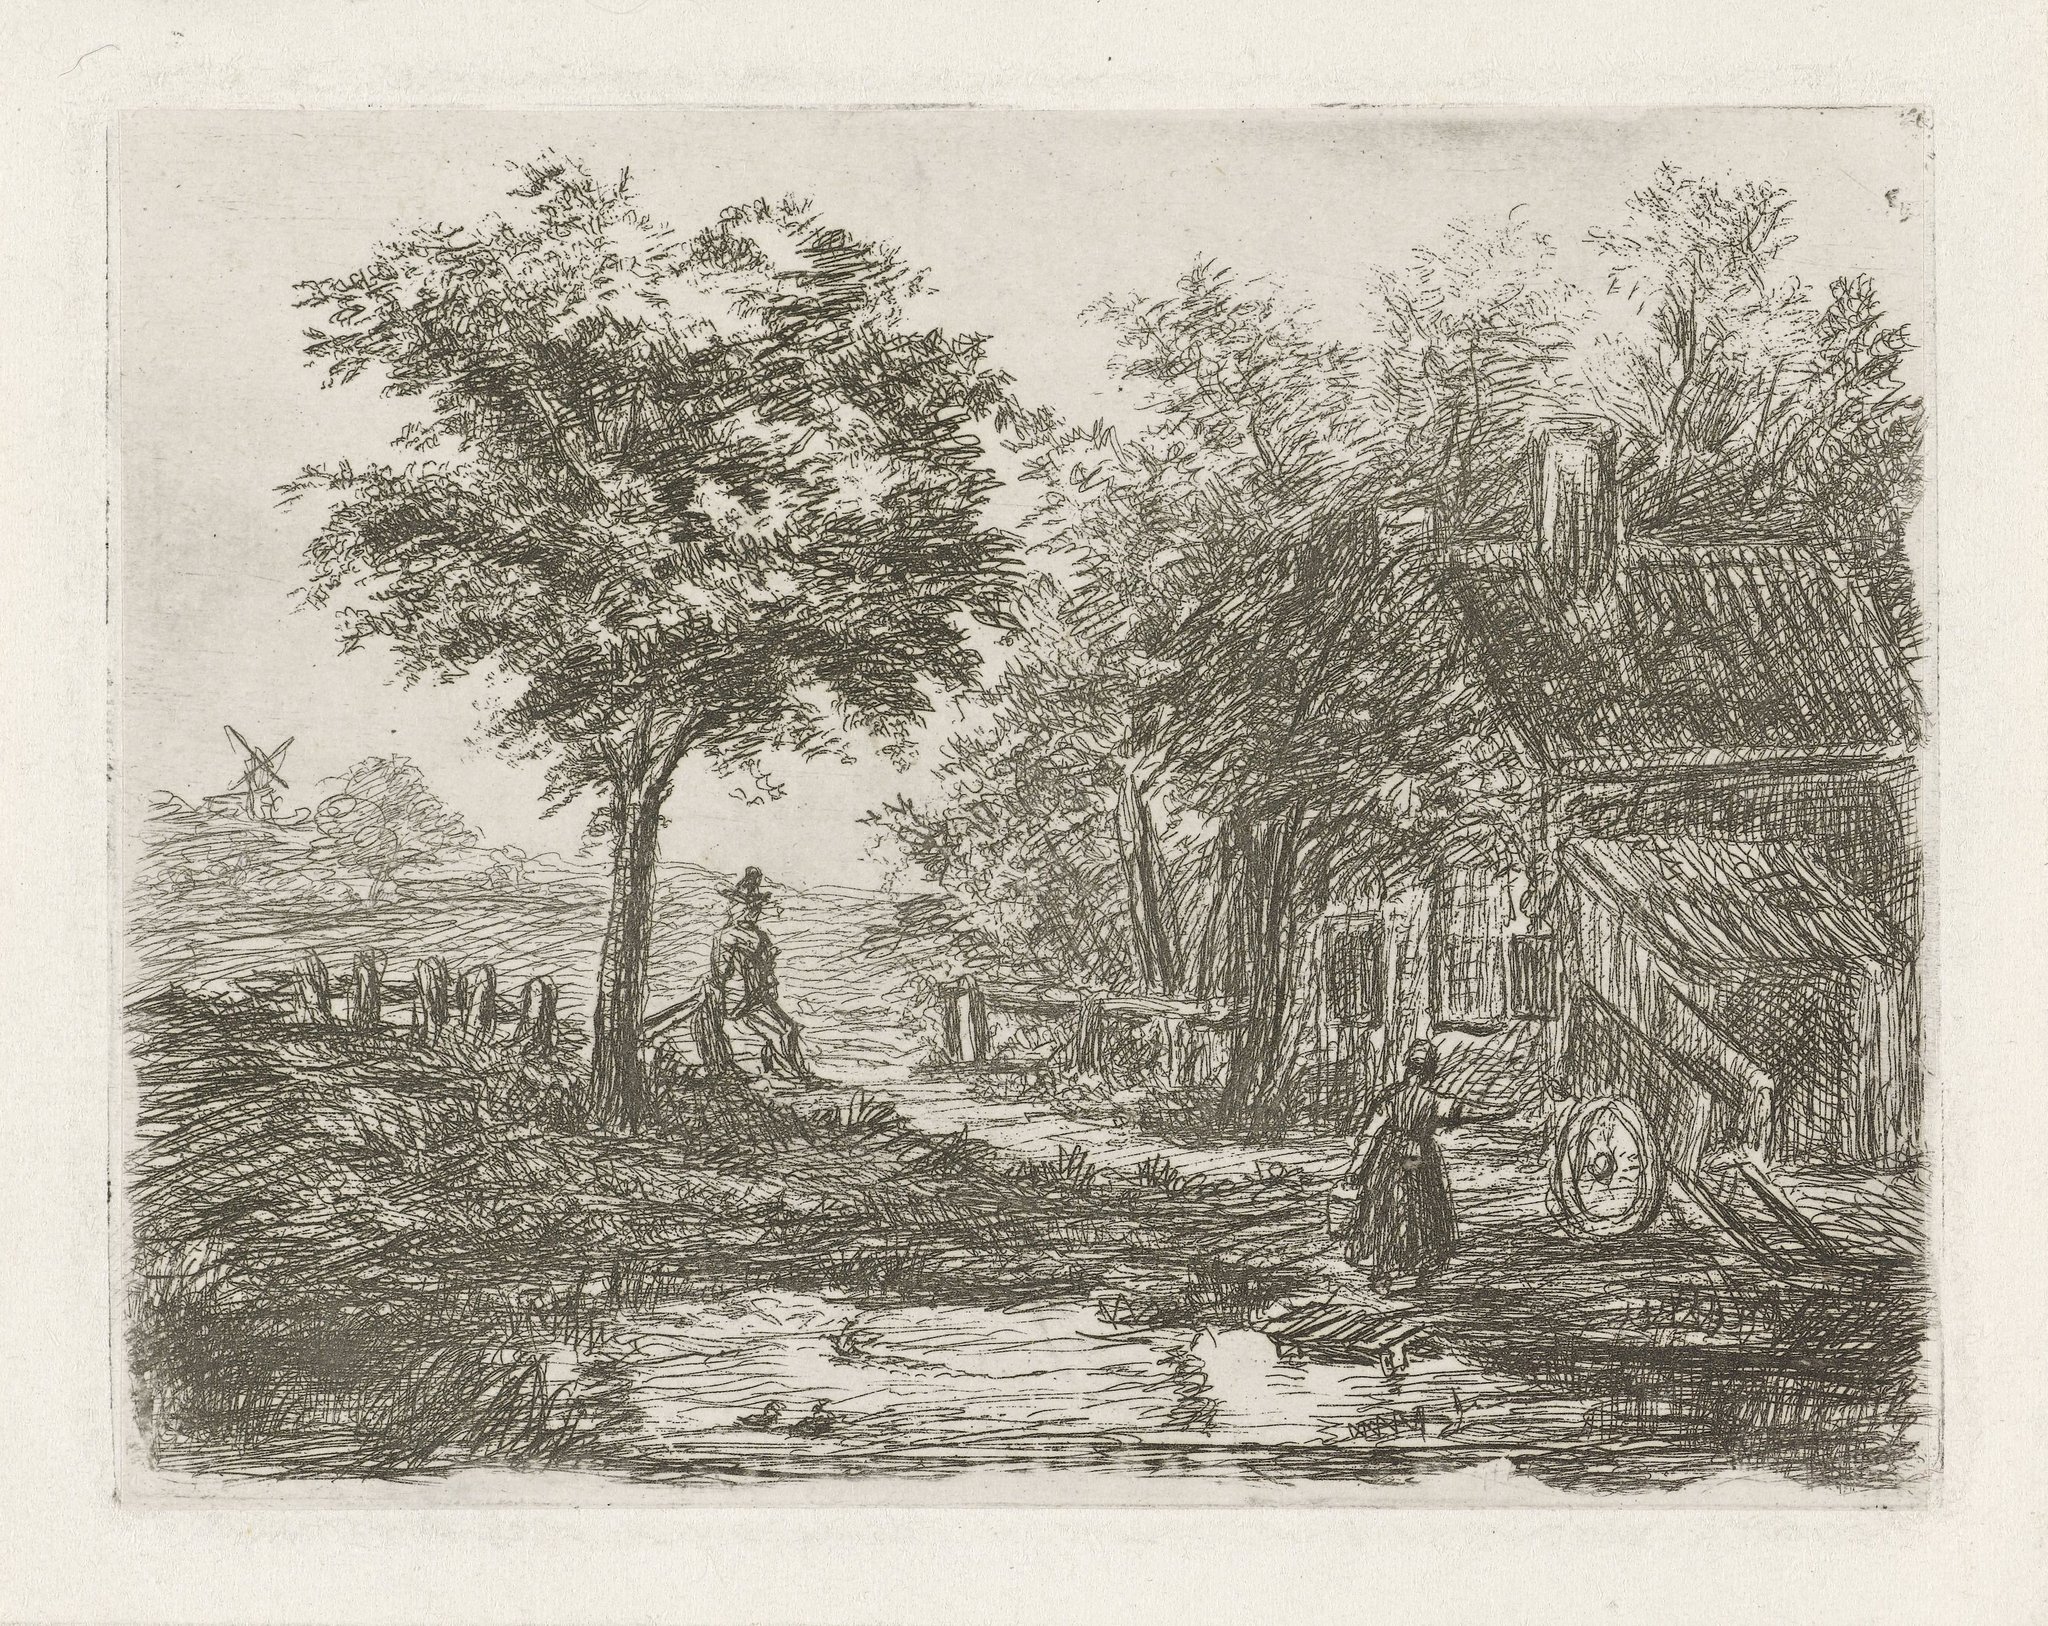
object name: print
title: Boerderij aan het water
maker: david van der kellen (1804-1879)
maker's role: die cutter, draughtsman, print maker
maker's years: 1804-1879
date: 1814-1879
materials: paper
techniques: etching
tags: windmill, farm or solitary house in landscape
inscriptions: collector's mark: Lugt 2228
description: Aan een watertje ligt een boerderij waarvoor een vrouw met een emmer en een man bij een hek. Op de achtergrond zijn de contouren van een molen zichtbaar.